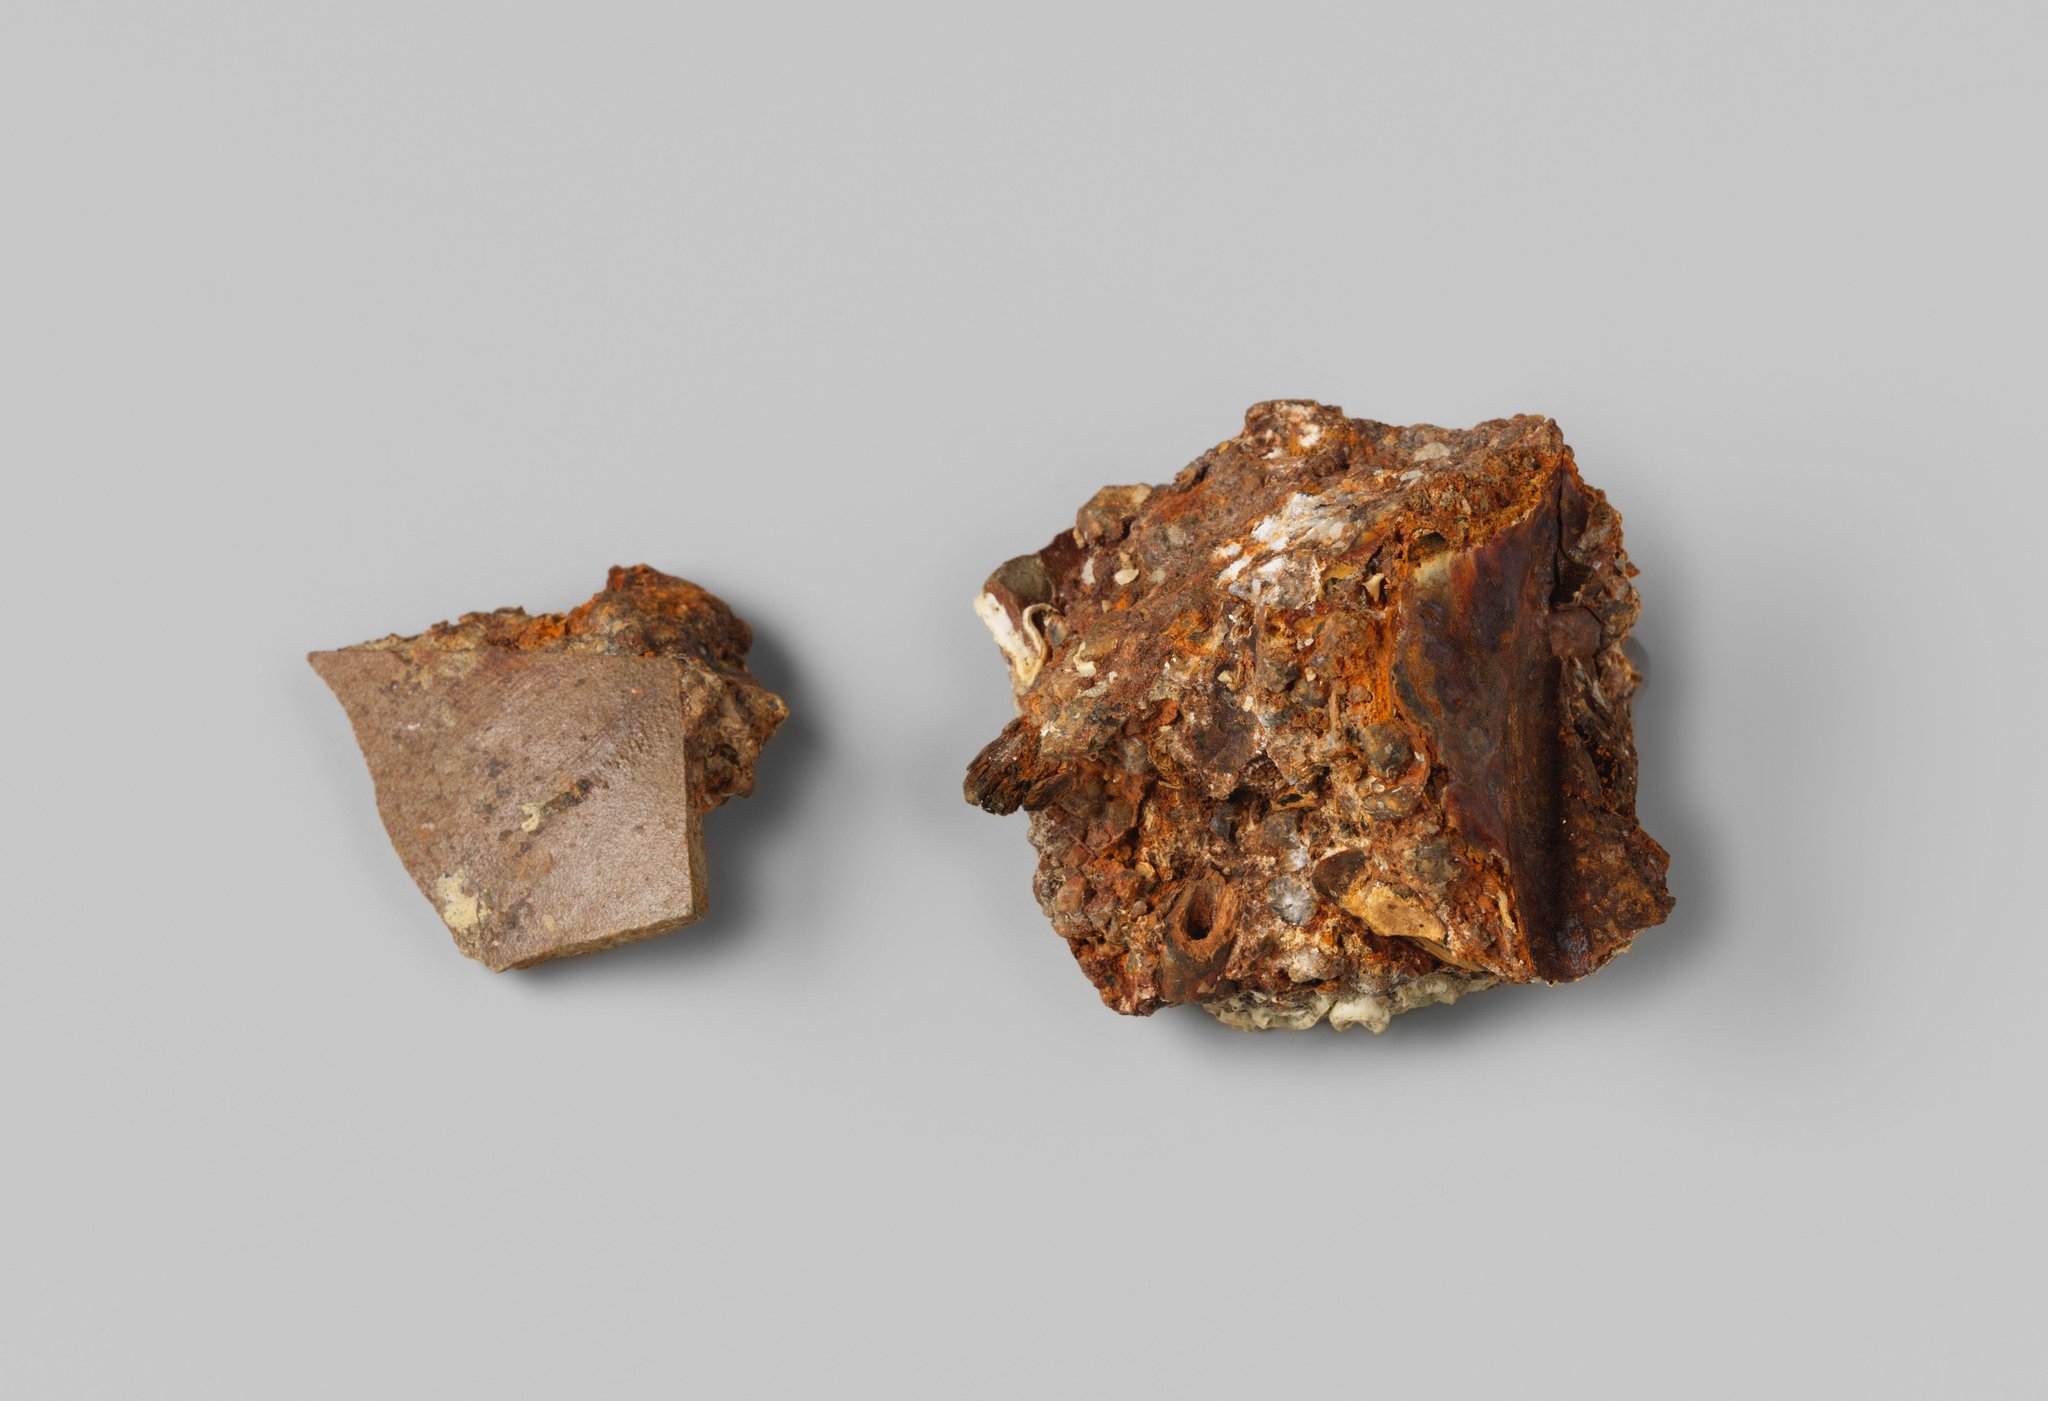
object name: concretionary stone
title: Concretie met insluitsel van steengoed uit het wrak van de Oostindiëvaarder Hollandia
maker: Anonymous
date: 1700-1743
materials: stone, stoneware